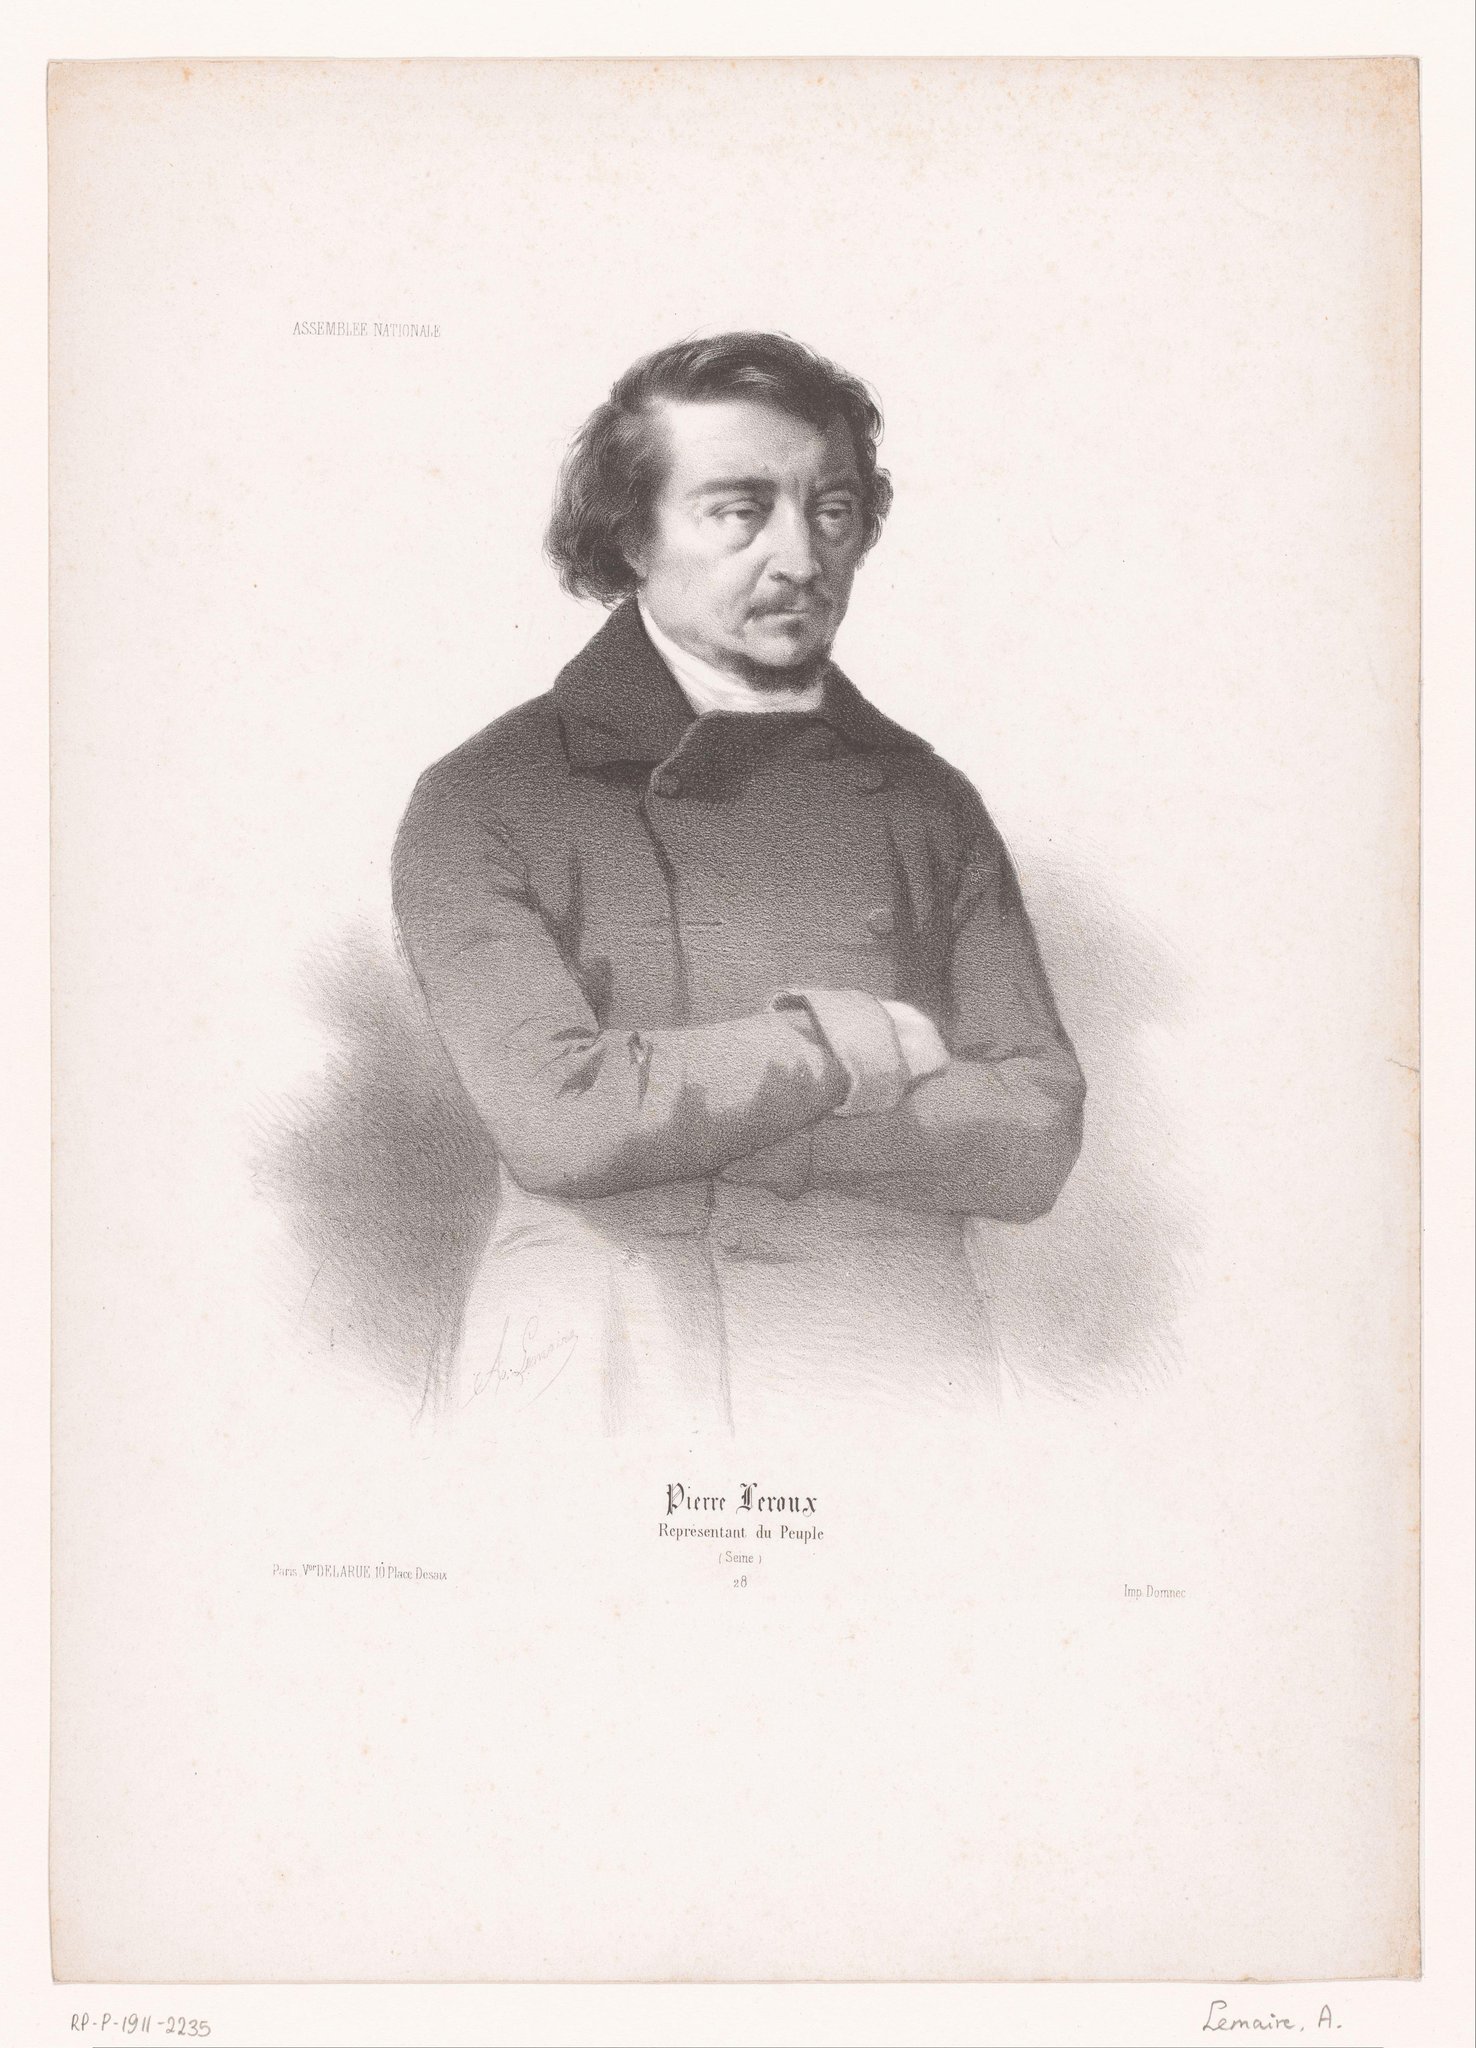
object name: print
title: Portret van Pierre Leroux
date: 1849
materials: paper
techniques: lithograph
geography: paris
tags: paris, politician, publisher, historical persons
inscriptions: collector's mark: Lugt 2228a